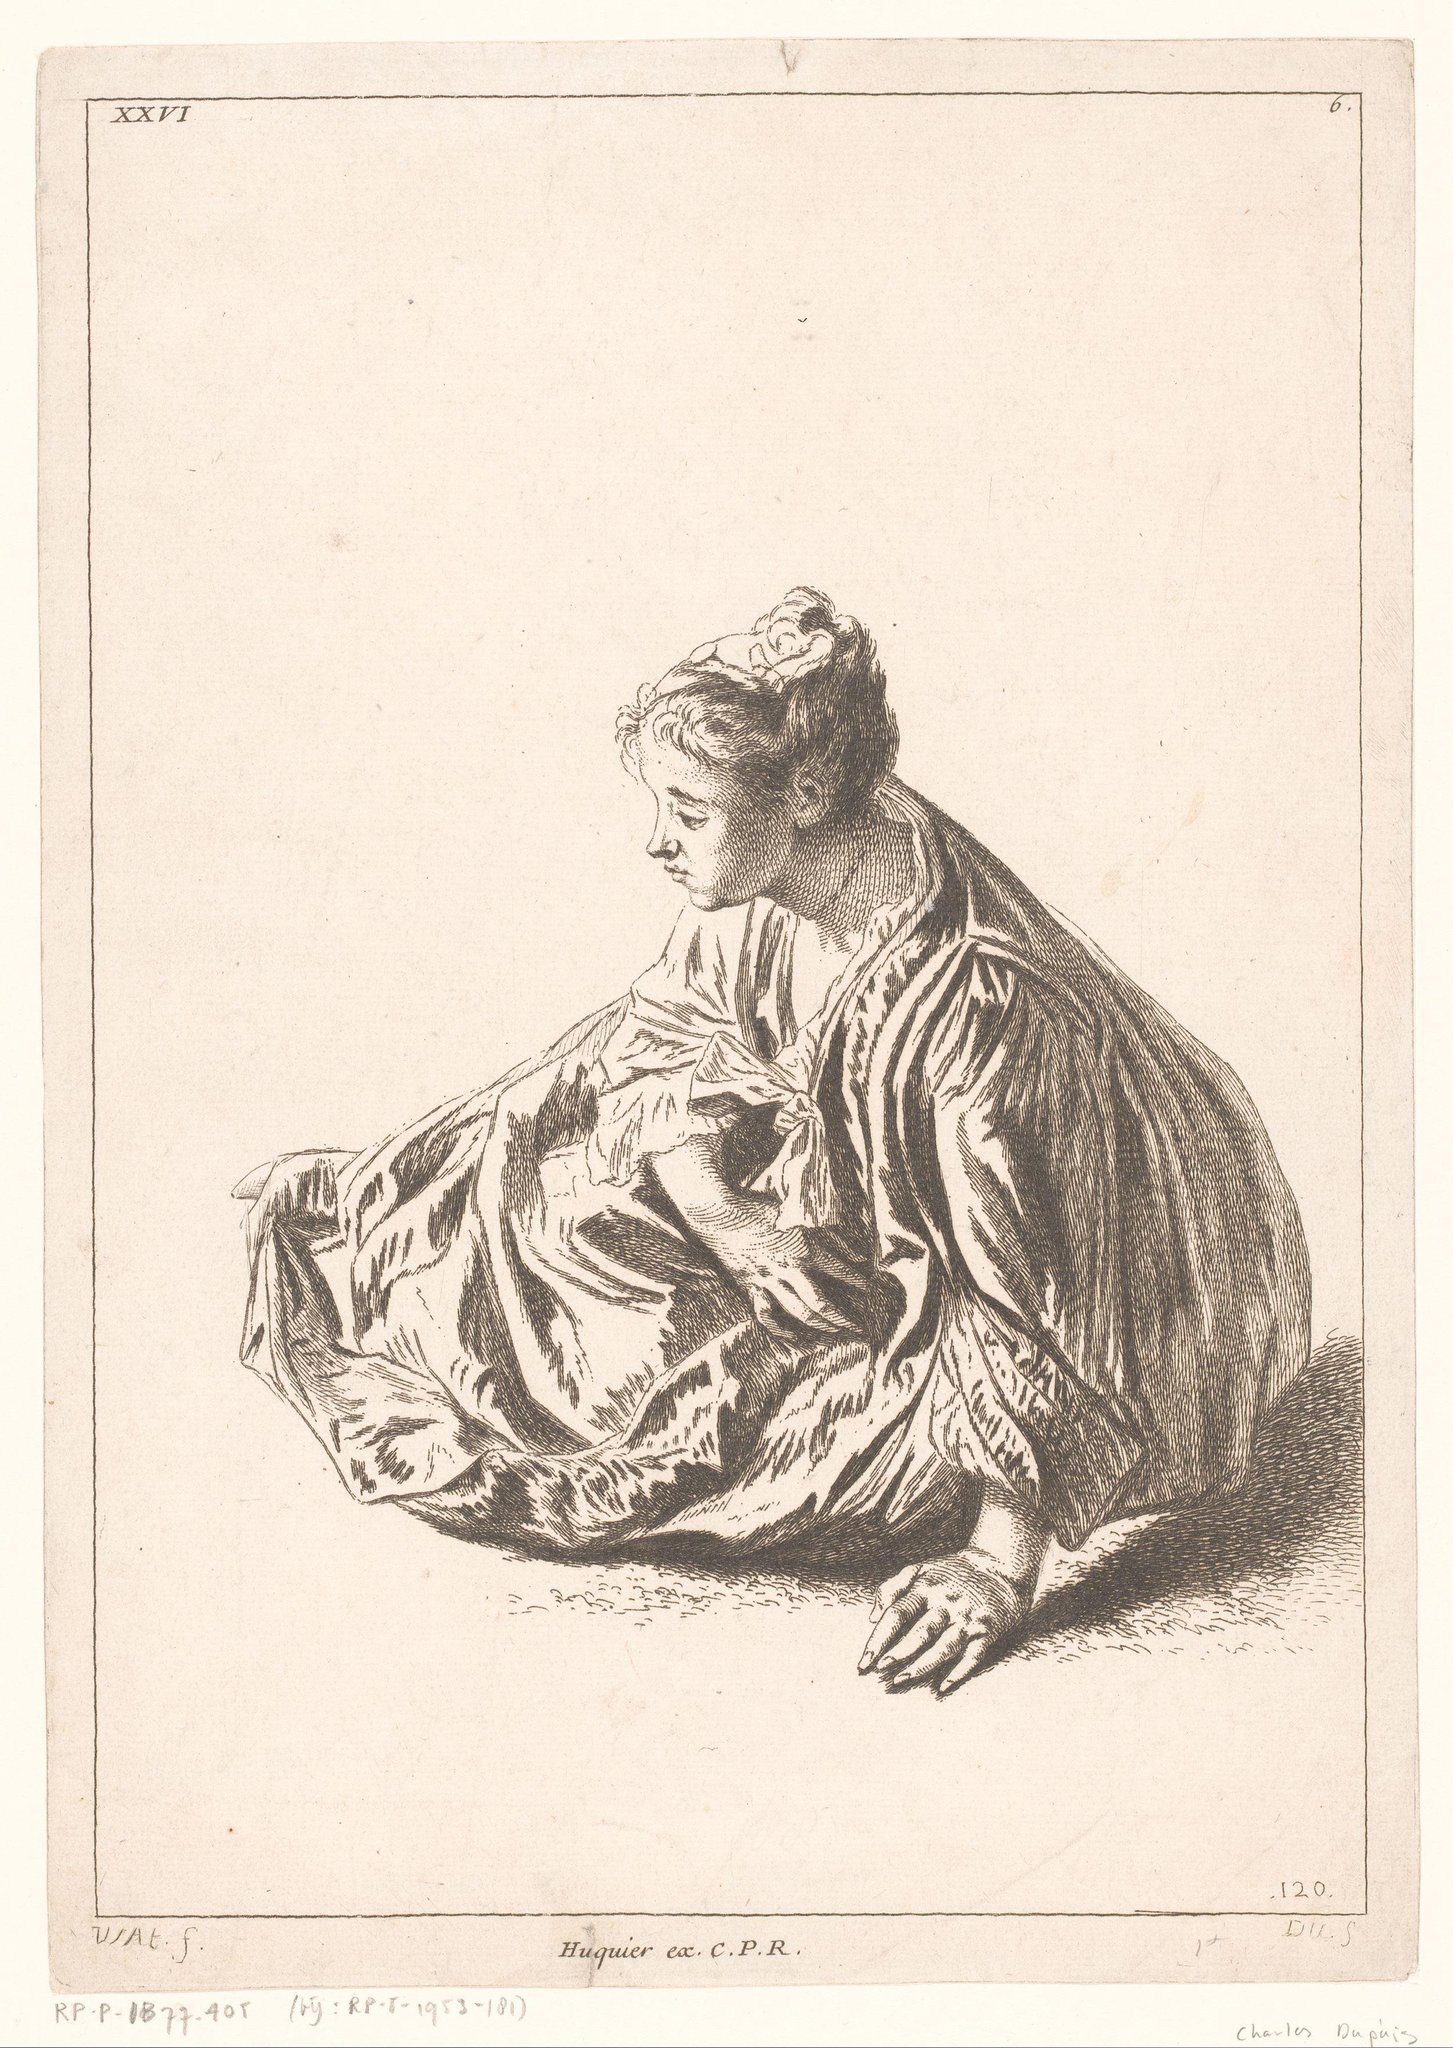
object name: print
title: Zittende vrouw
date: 1710-1742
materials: paper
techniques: etching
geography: paris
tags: adult woman, dress, gown (+ women's clothes), sitting on the ground - aa - female human figure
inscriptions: collector's mark: Lugt 533b